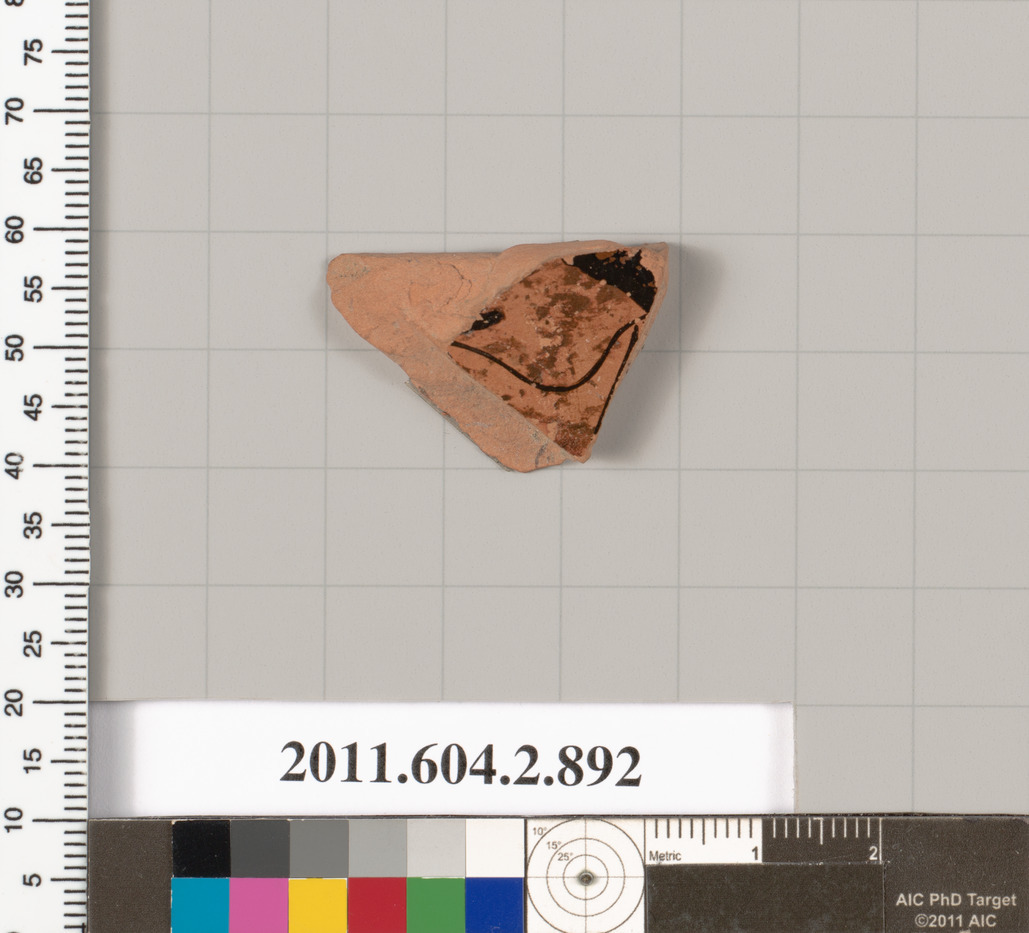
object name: bell krater fragment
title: Terracotta fragment of a bell-krater (bowl for mixing wine and water)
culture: greek, attic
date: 470-450 BCE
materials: terracotta